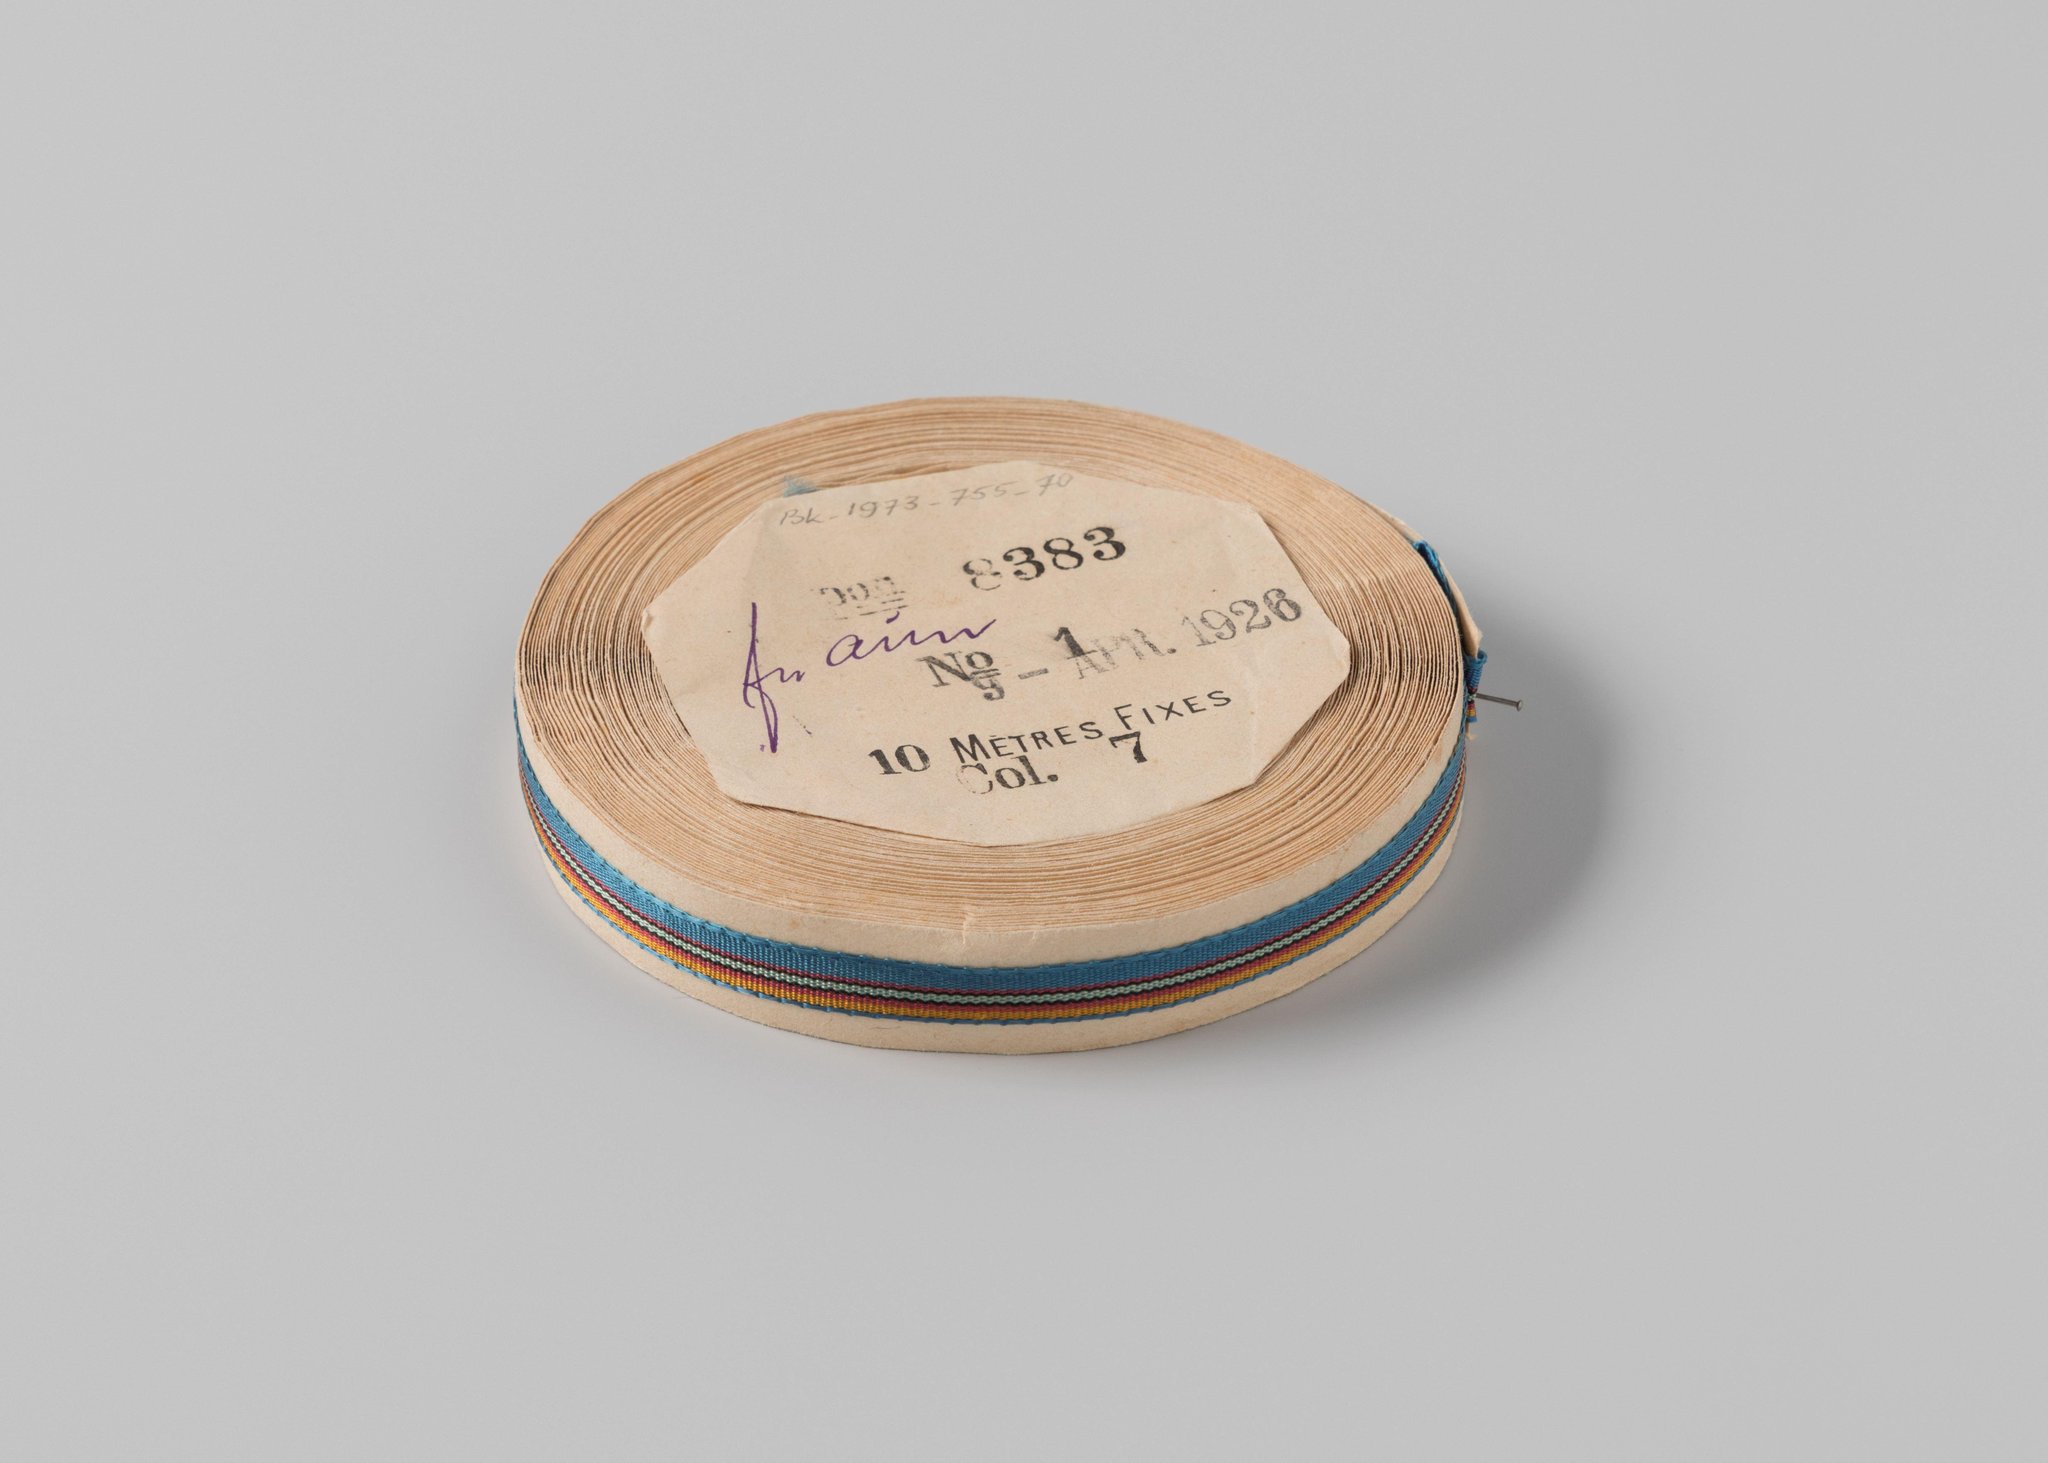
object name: ribbon material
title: Lint op rol, gestreept, blauw met magenta, zwart, groen en oranje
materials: cardboard, paper, textile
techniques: weave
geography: nijmegen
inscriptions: stamp: ‘9 - APR. 1926’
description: Lint op rol, gestreept, blauw met magenta, zwart, groen en oranje.